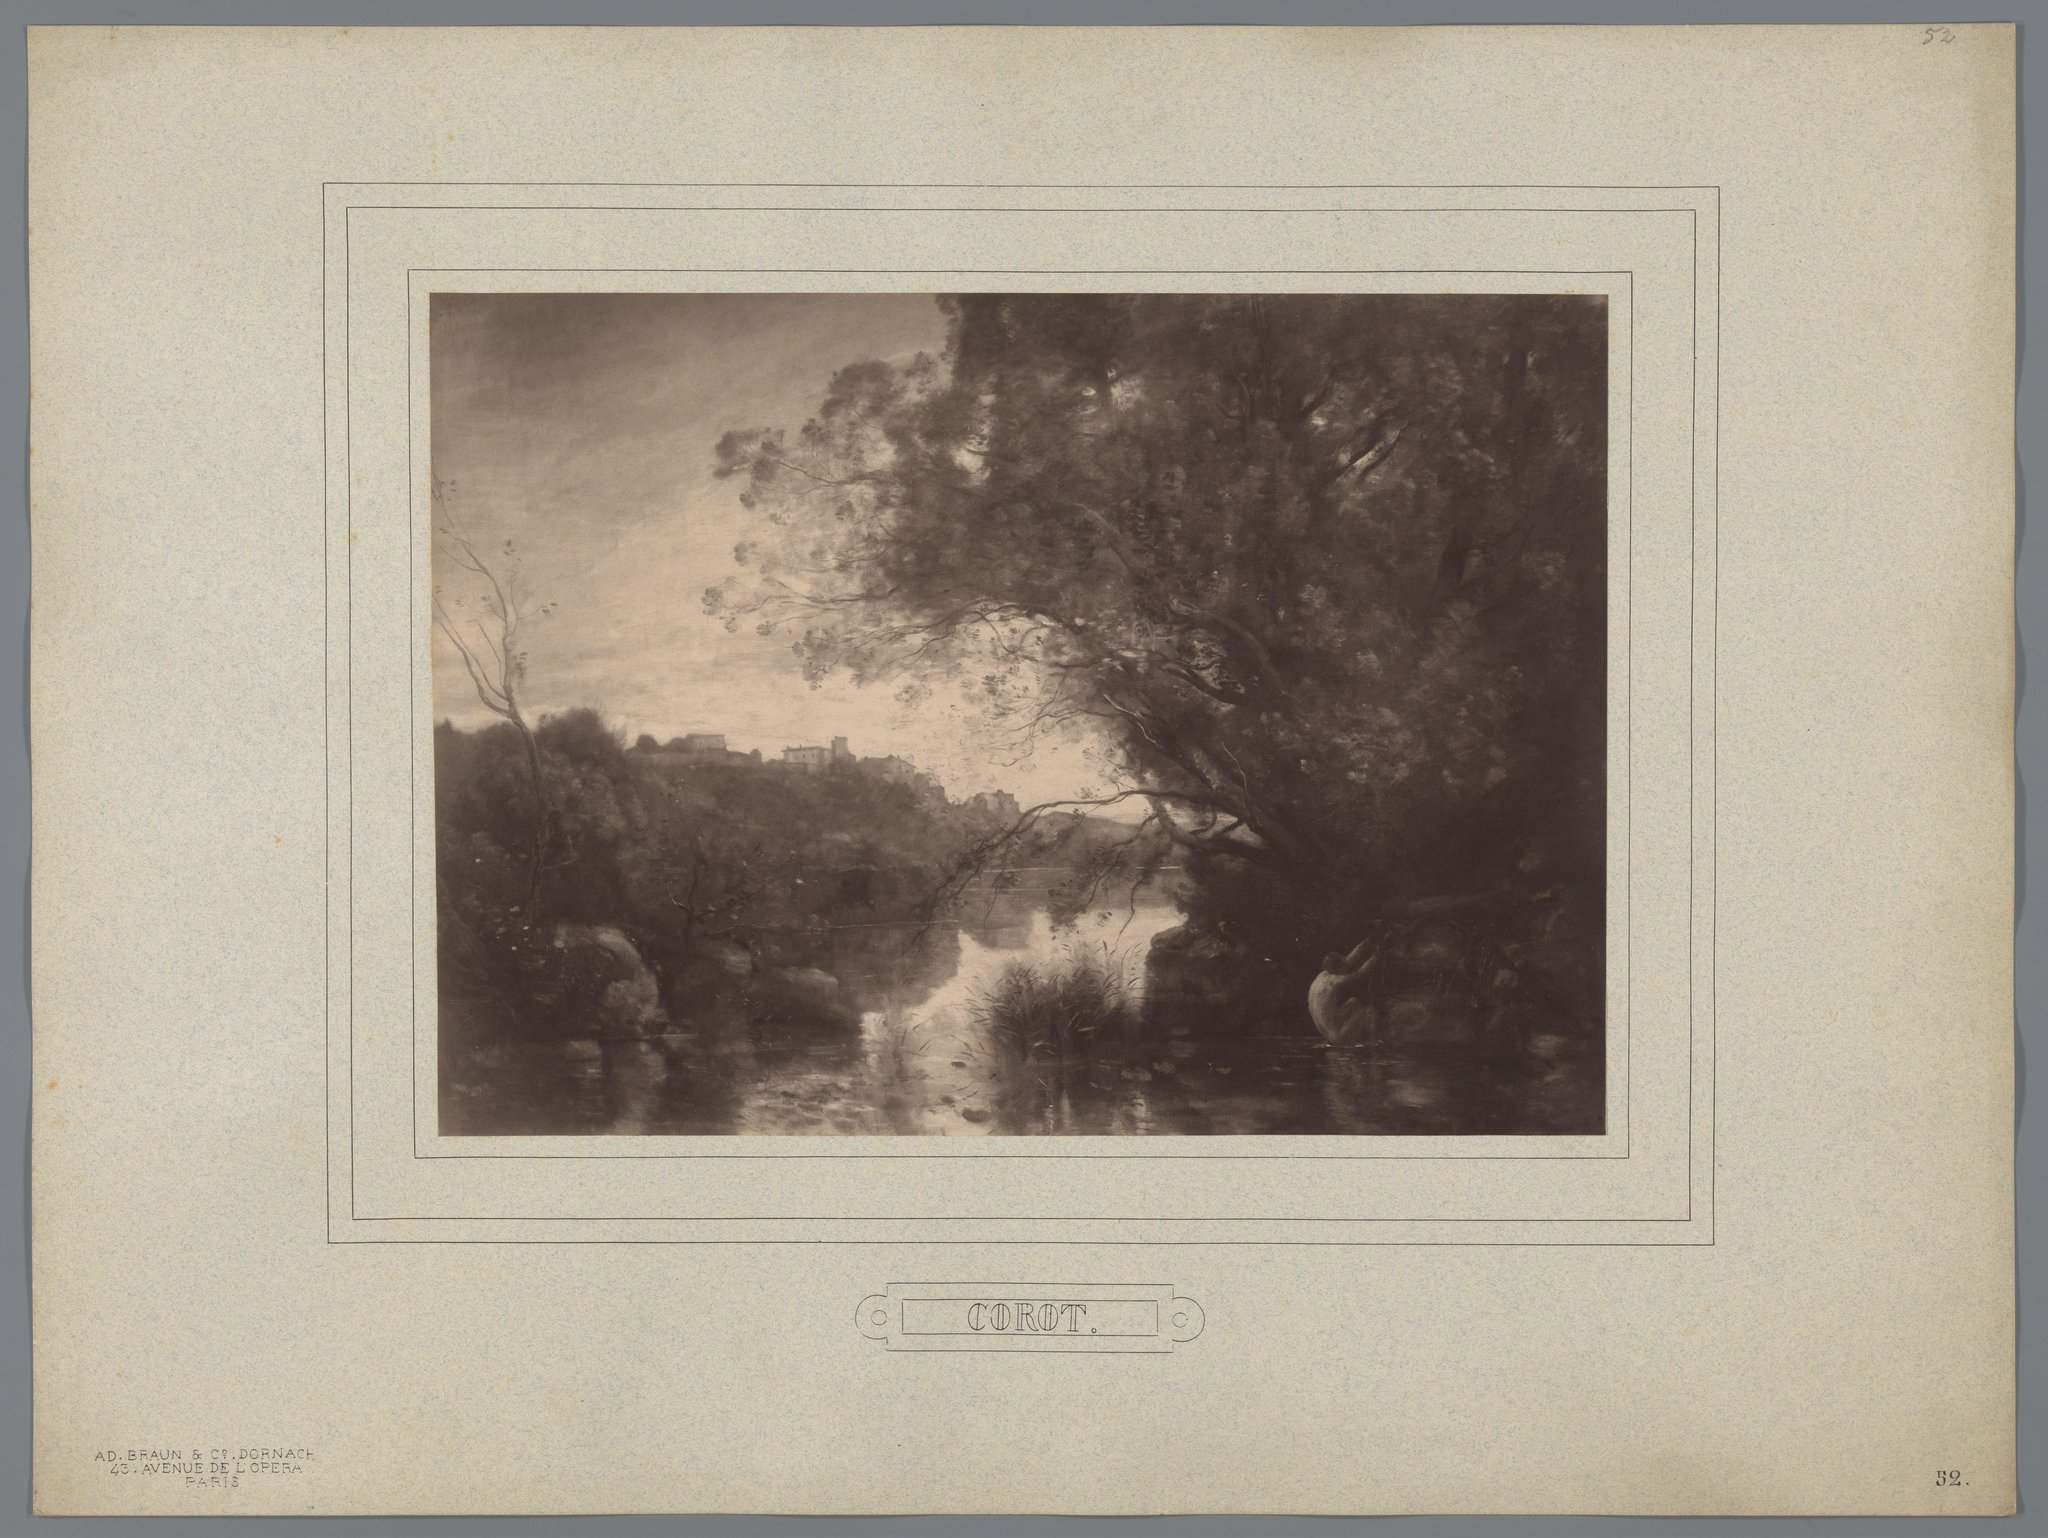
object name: photograph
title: Fotoreproductie van een schilderij van Camille Corot (landschap)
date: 1880-1900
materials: cardboard, paper, photographic support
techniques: carbon print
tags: painter, print maker, draughtsman, camille corot